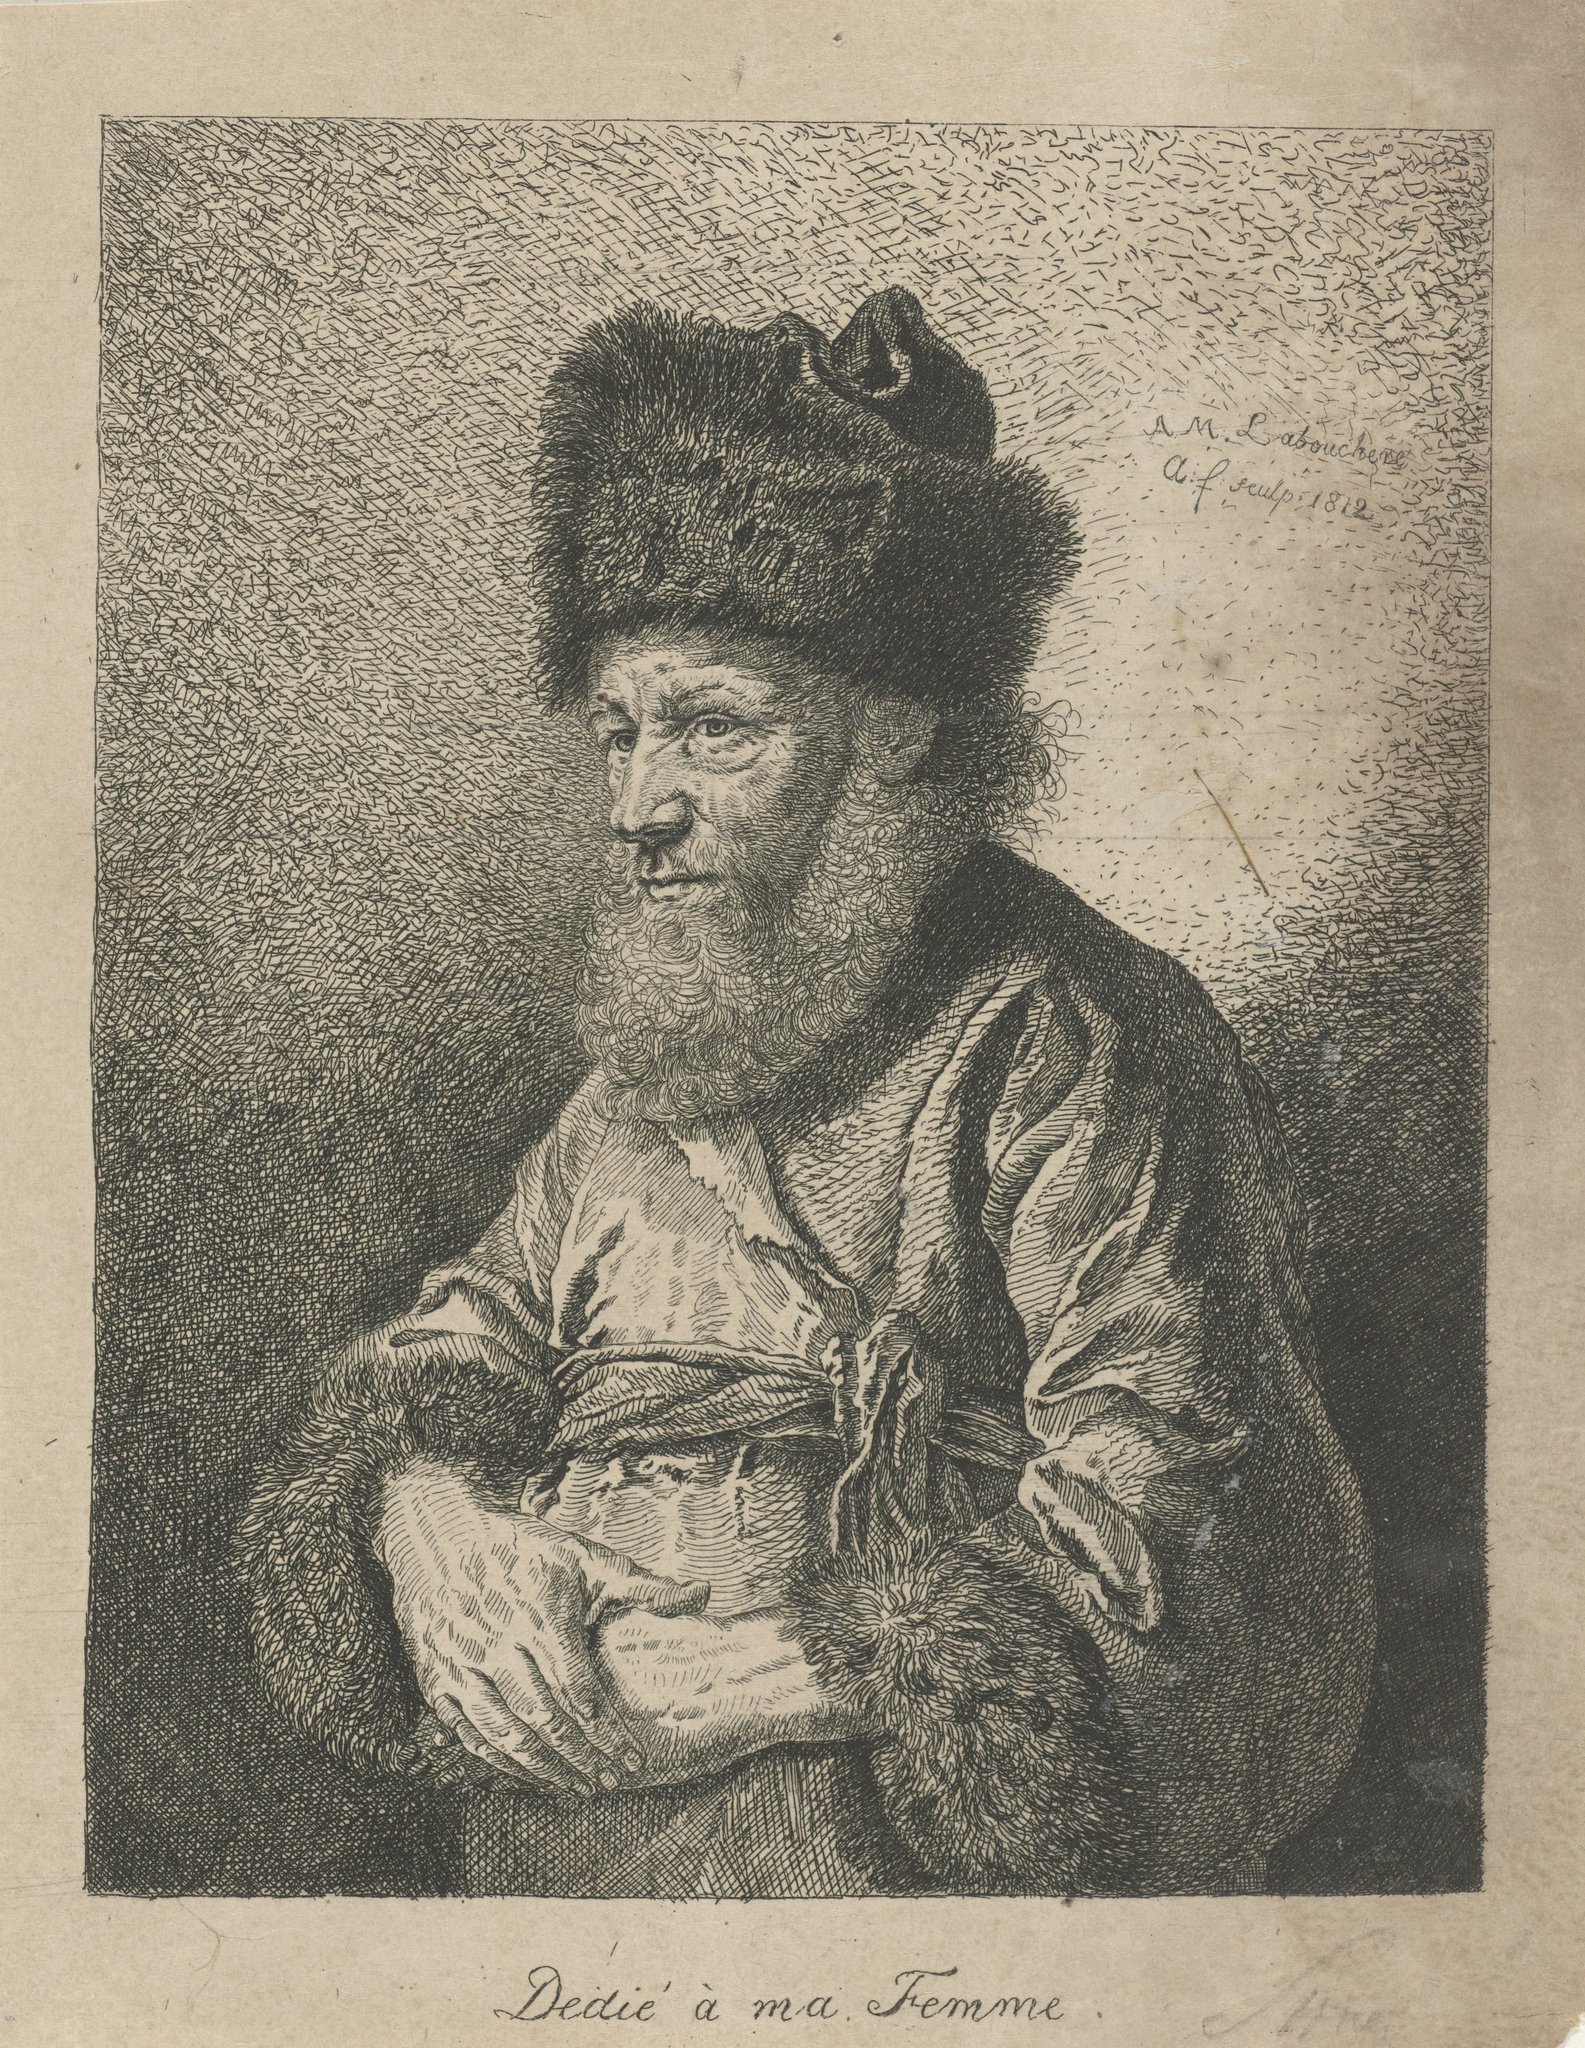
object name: print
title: Portret van een onbekende oude man met bontmuts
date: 1812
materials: paper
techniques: etching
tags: anonymous historical person portrayed alone, head-gear: cap (+ men's clothes)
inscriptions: collector's mark: Lugt 2228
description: Portret van Jechiel Michel Hirsch, rabbijn te Potsdam, naar links.